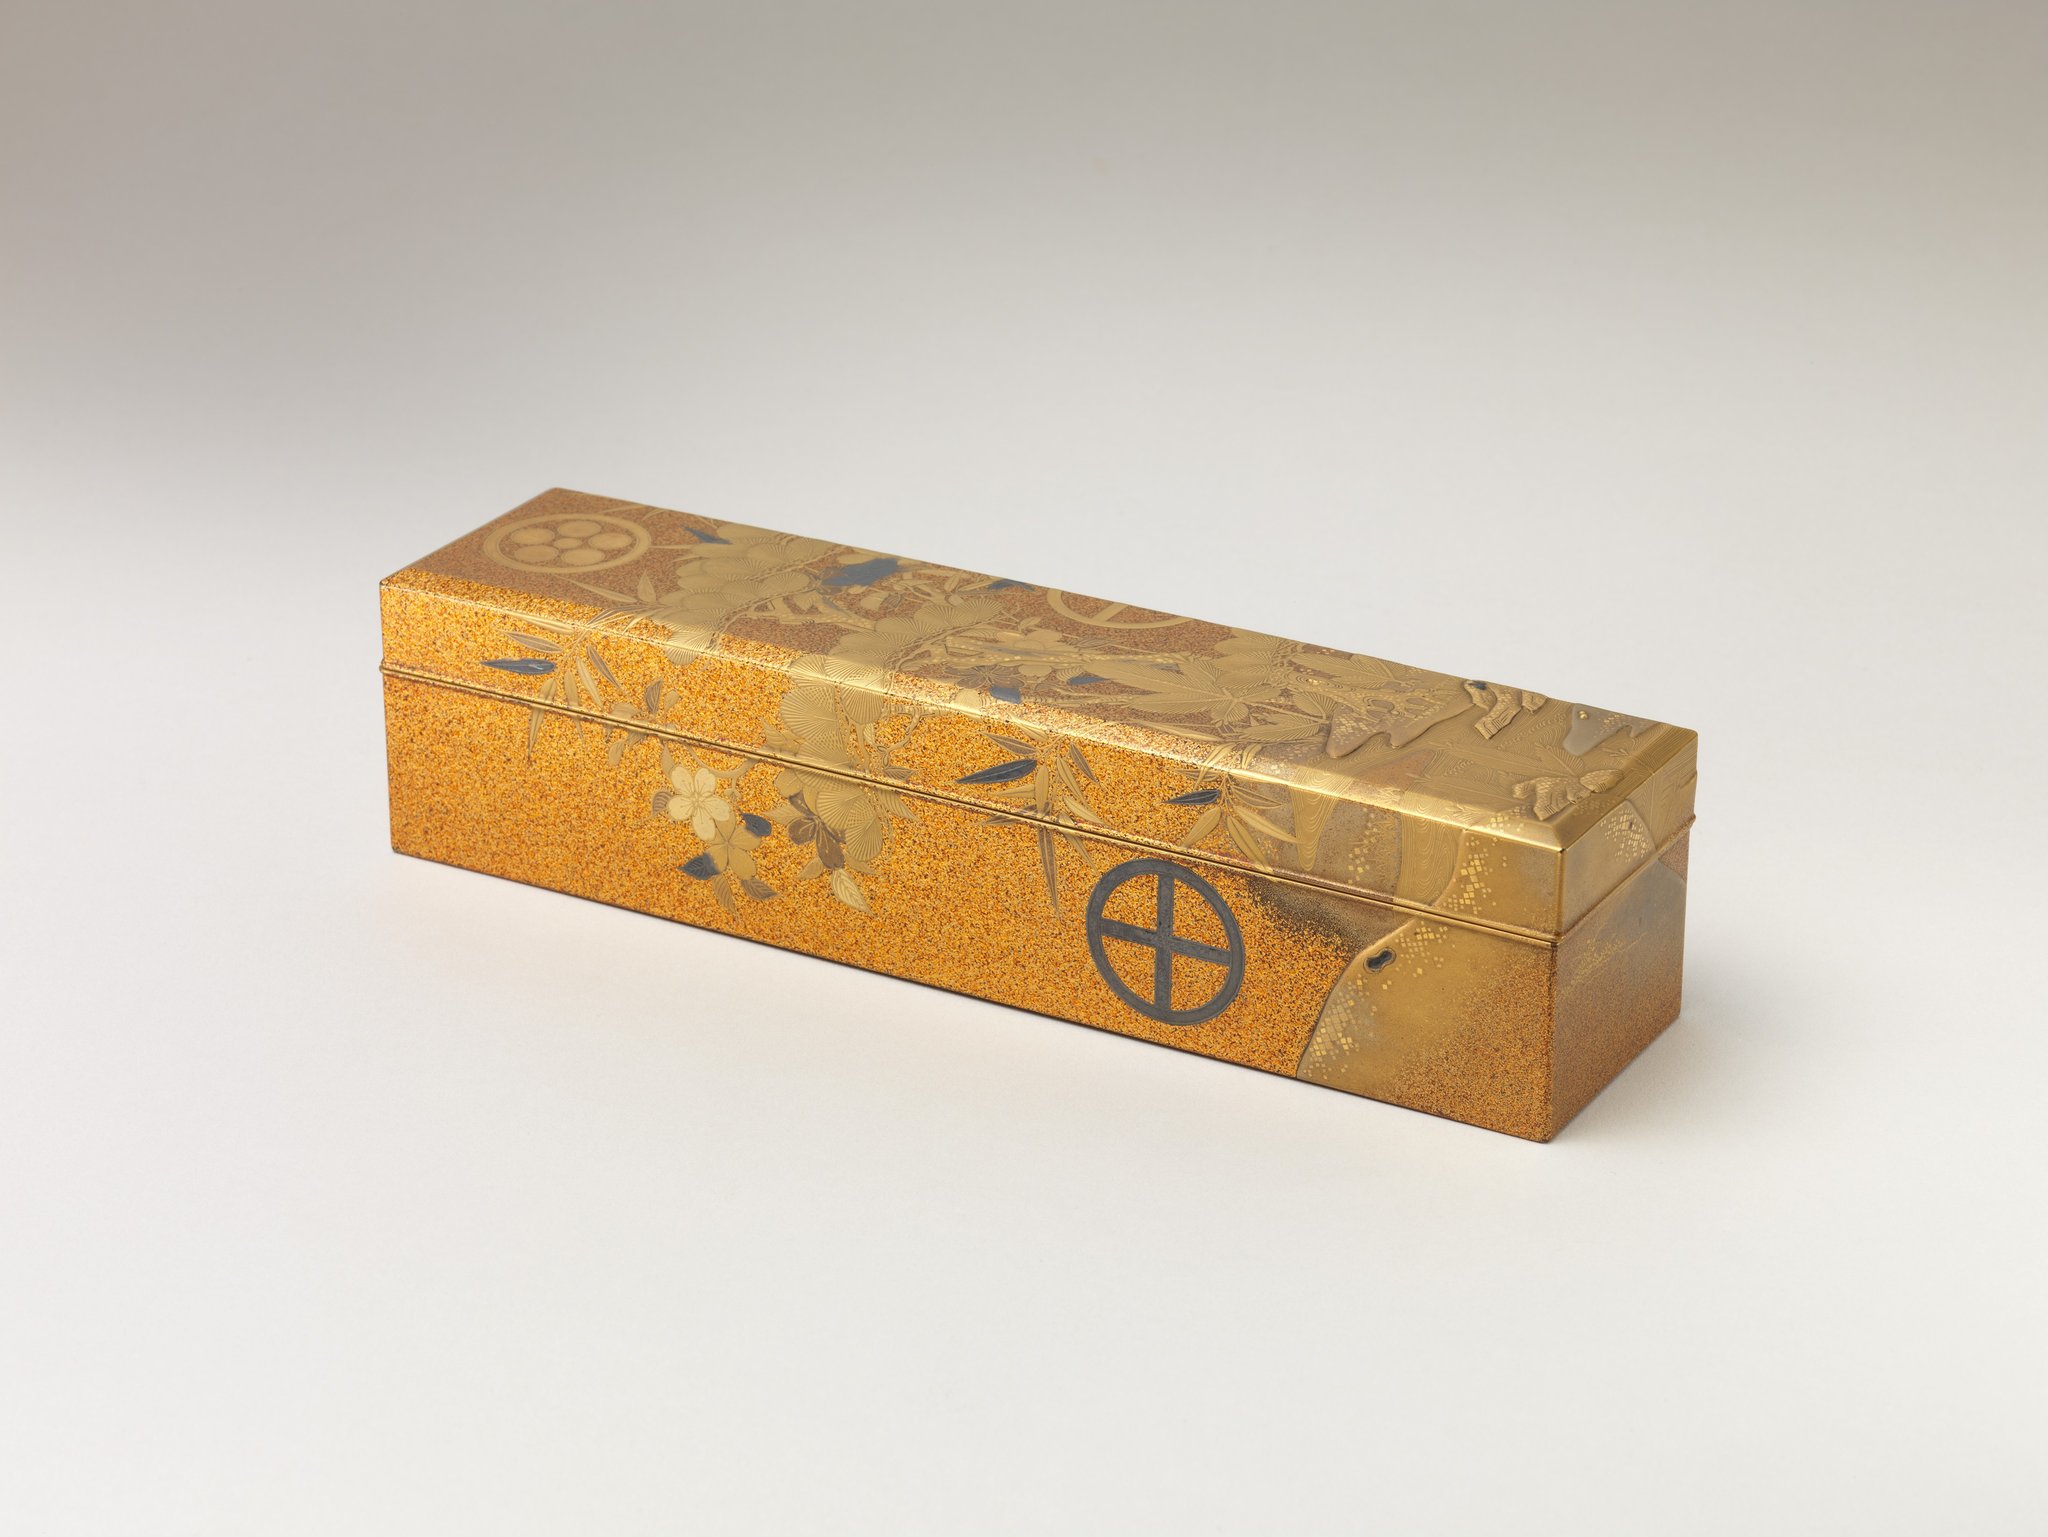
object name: box with cover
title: Covered Box with Design of Pine, Bamboo, and Cherry Blossom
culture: japanese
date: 1801-1900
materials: gold, lacquer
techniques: maki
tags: flowers